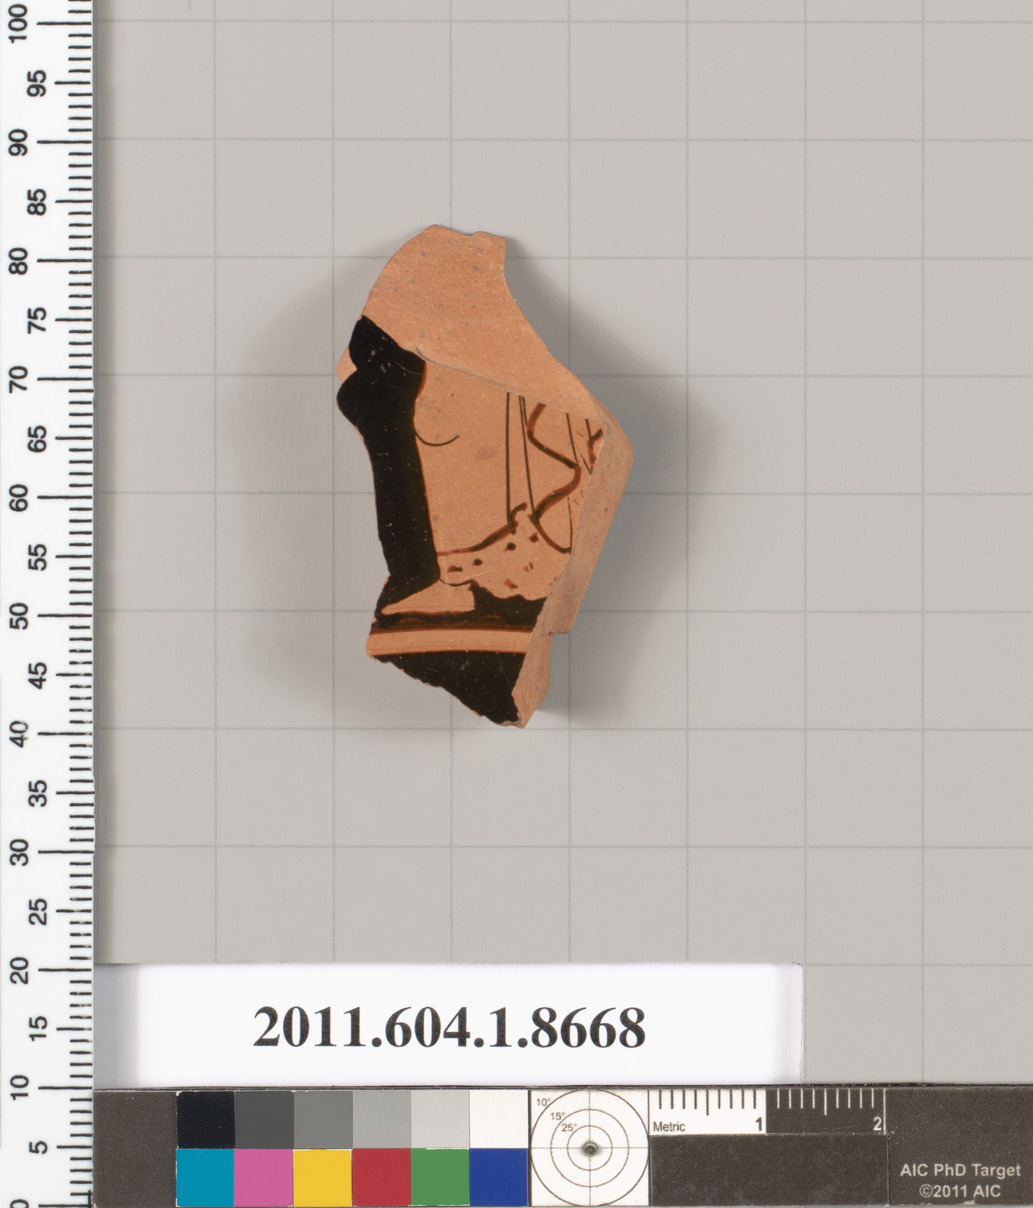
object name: kylix fragment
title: Terracotta rim fragment of a stemless? kylix (drinking cup)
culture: greek, attic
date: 450-440 BCE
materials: terracotta